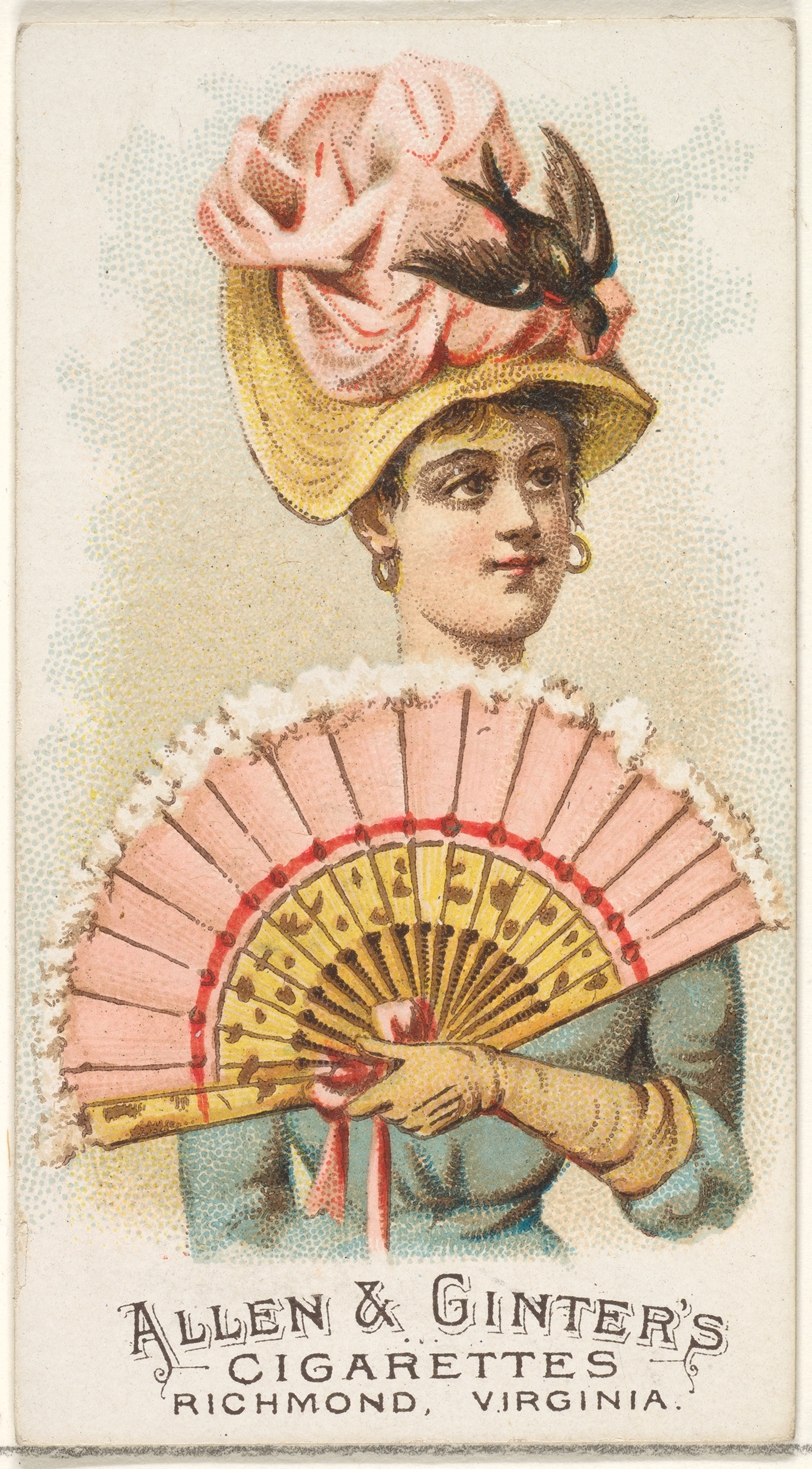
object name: print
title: Plate 27, from the Fans of the Period series (N7) for Allen & Ginter Cigarettes Brands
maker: allen & ginter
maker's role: publisher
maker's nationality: american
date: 1889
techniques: color lithograph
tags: fans,women